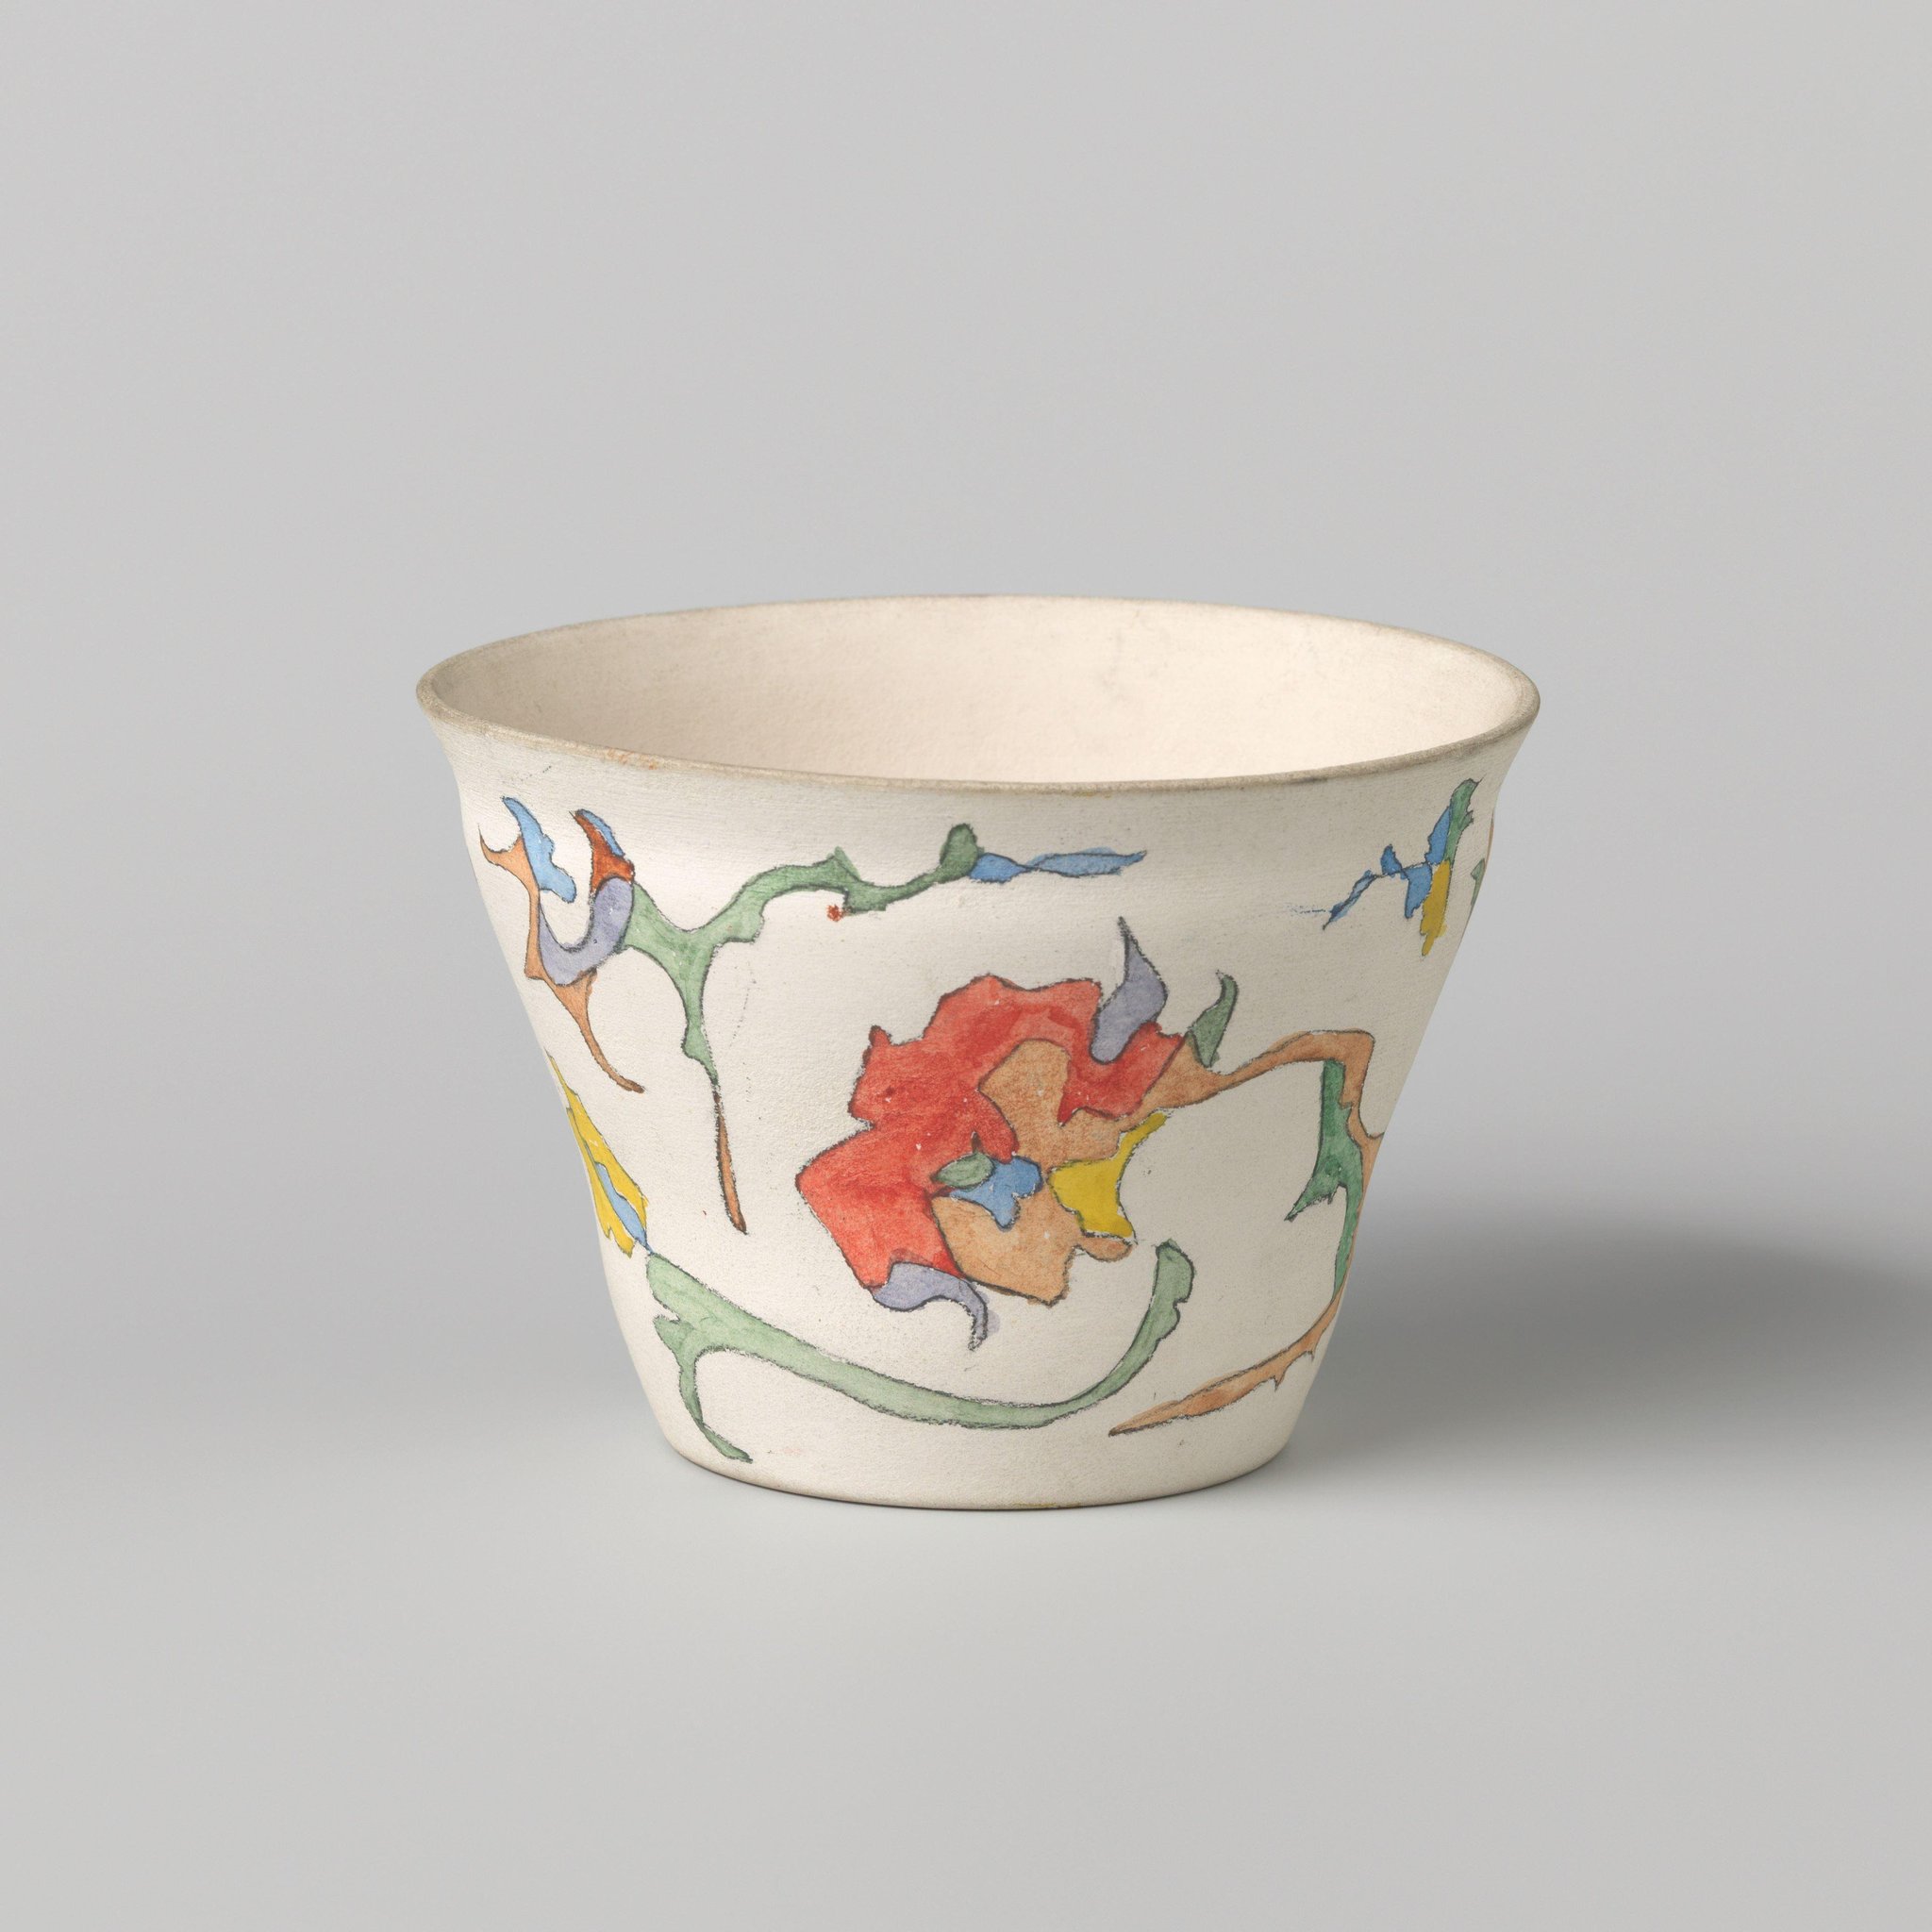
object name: cup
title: Kop zonder oor, polychroom beschilderd met waterverf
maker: theo colenbrander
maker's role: draughtsman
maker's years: 1841-1930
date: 1920-1922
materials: earthenware, watercolor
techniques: painted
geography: arnhem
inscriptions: mark, inscription: ‘Gebloemd’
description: Kop van aardewerk zonder oor, polychroom beschilderd met waterverf, ongeglazuurd.